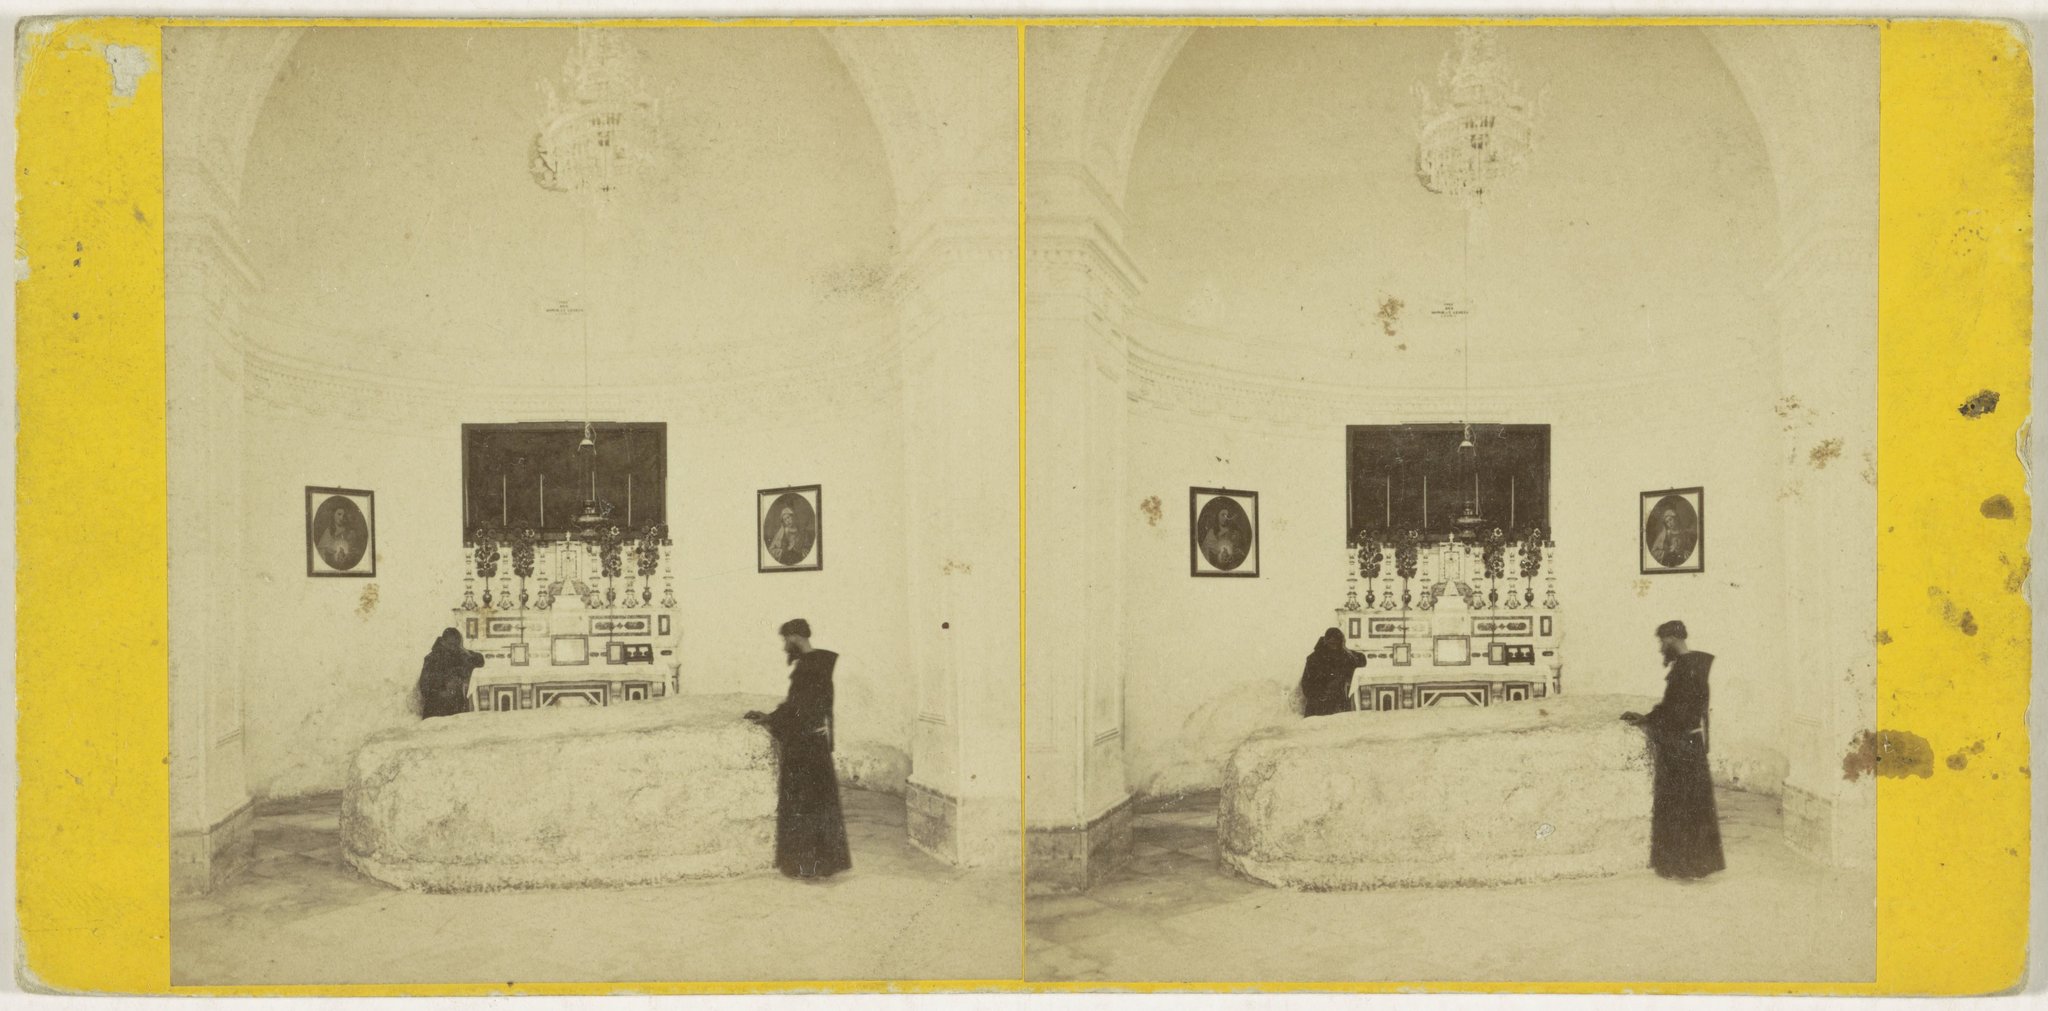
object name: stereograph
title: Kapel in de Mensa Christi, Nazareth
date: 1860-1880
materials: cardboard, paper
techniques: albumen print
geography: mensa christi church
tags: parts of church interior: chapel, mensa christi church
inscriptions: inscription: ‘This, according to the tradition, is the very table at which Our/ Lord and his Disciples frequently ate both before / and after His resurrection.’, number: ‘No. 309.’